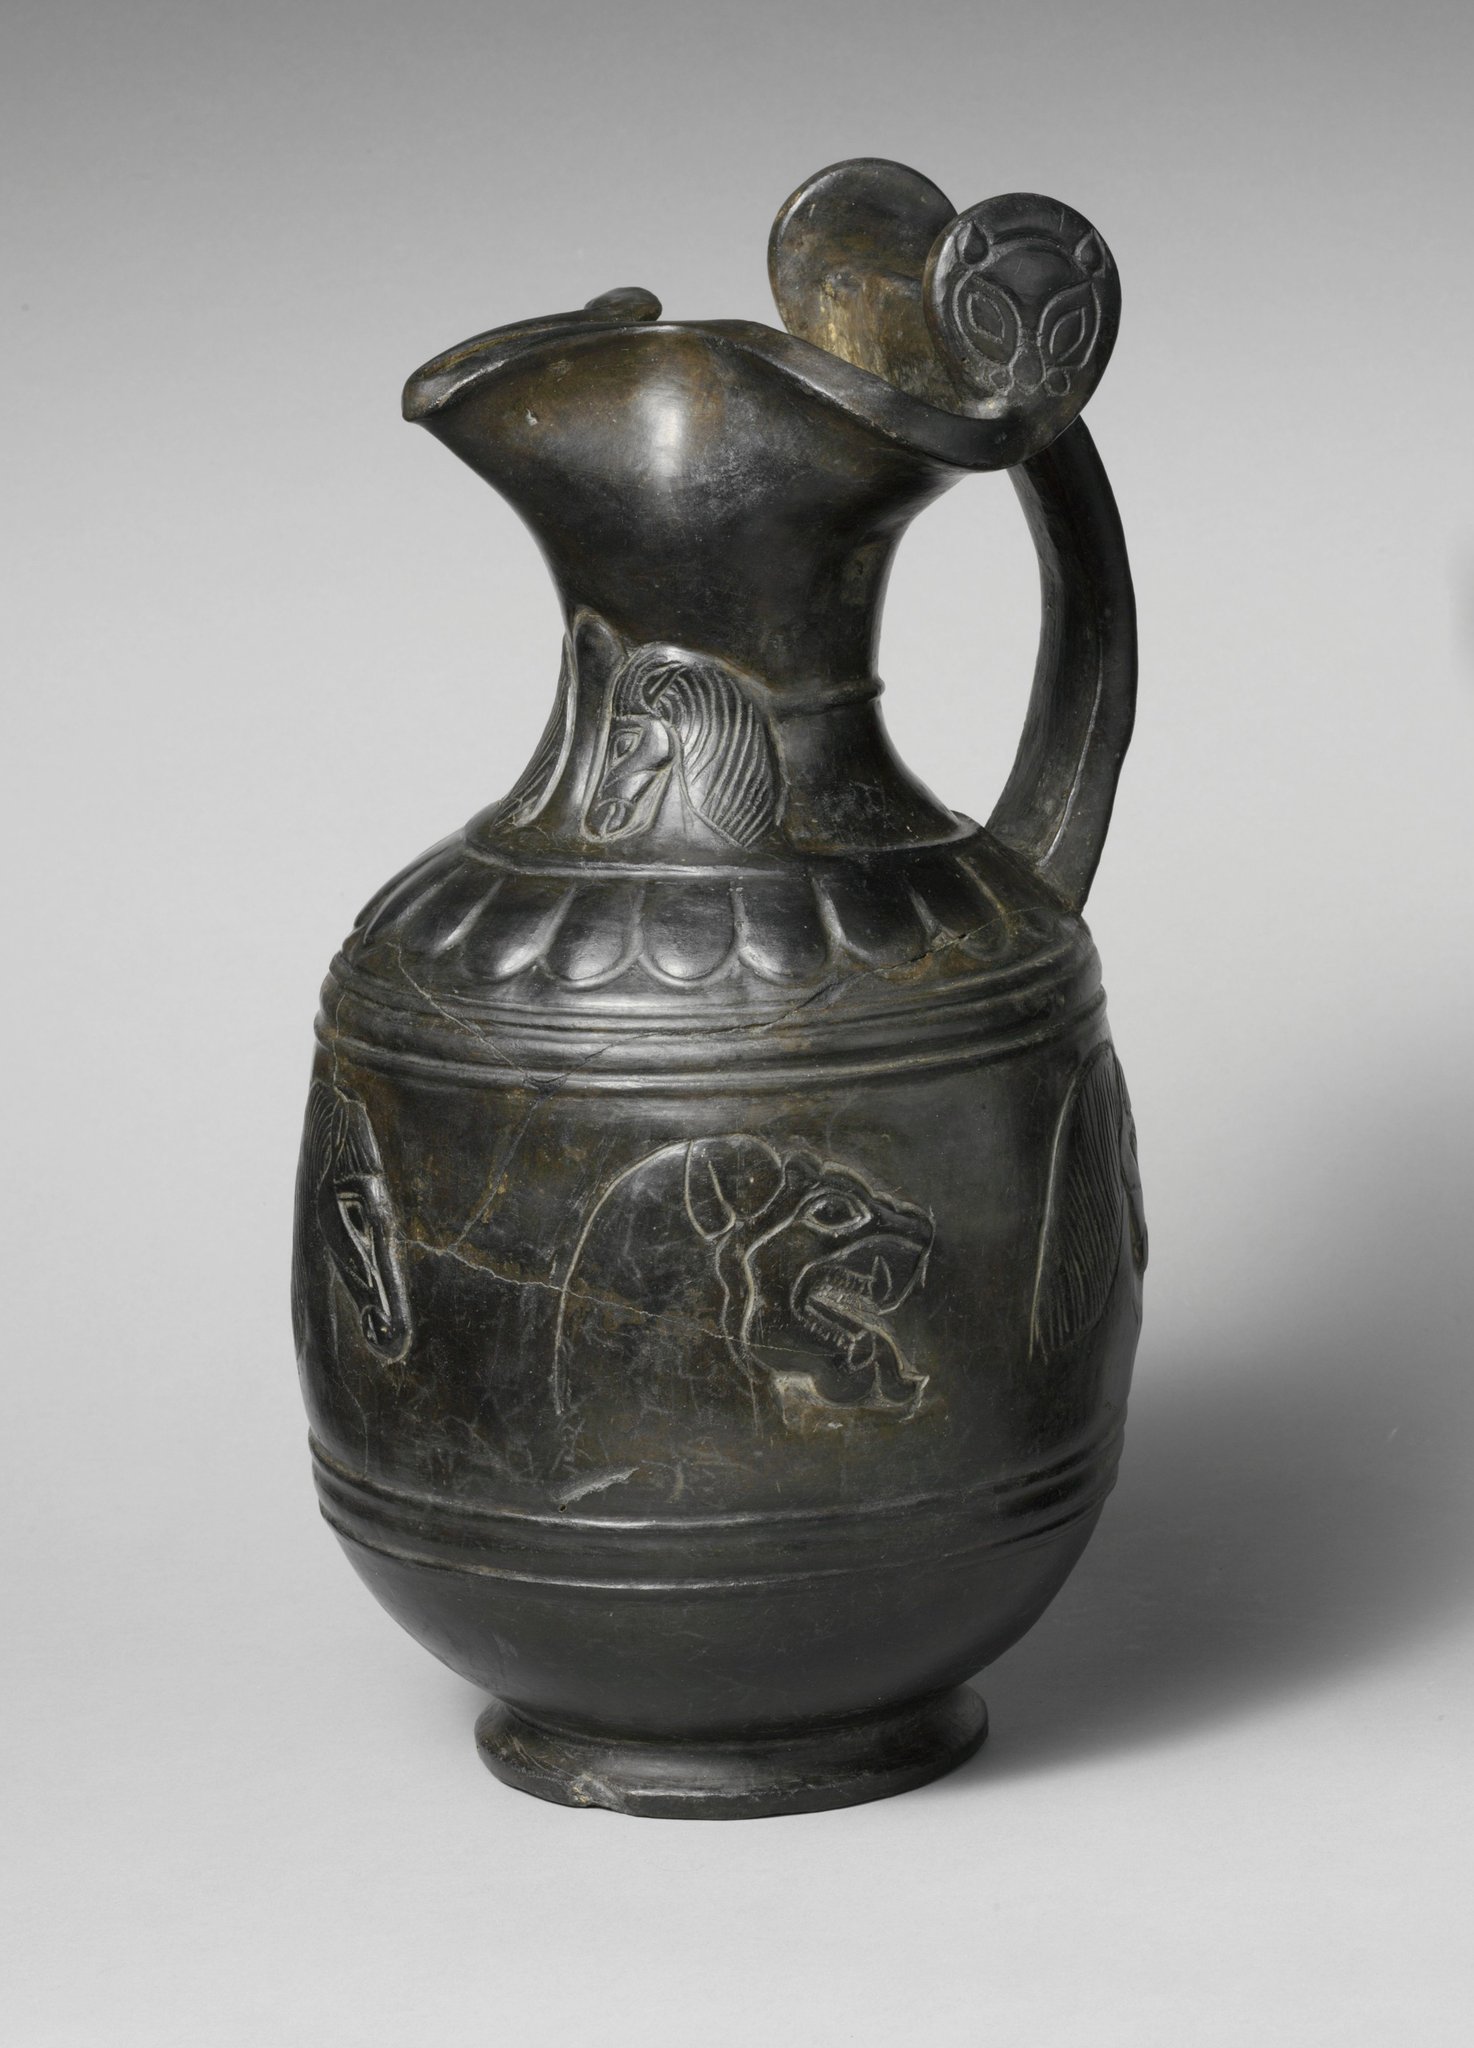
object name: oinochoe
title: Terracotta trefoil oinochoe (jug)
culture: etruscan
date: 550 BCE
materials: terracotta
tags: horses,lions